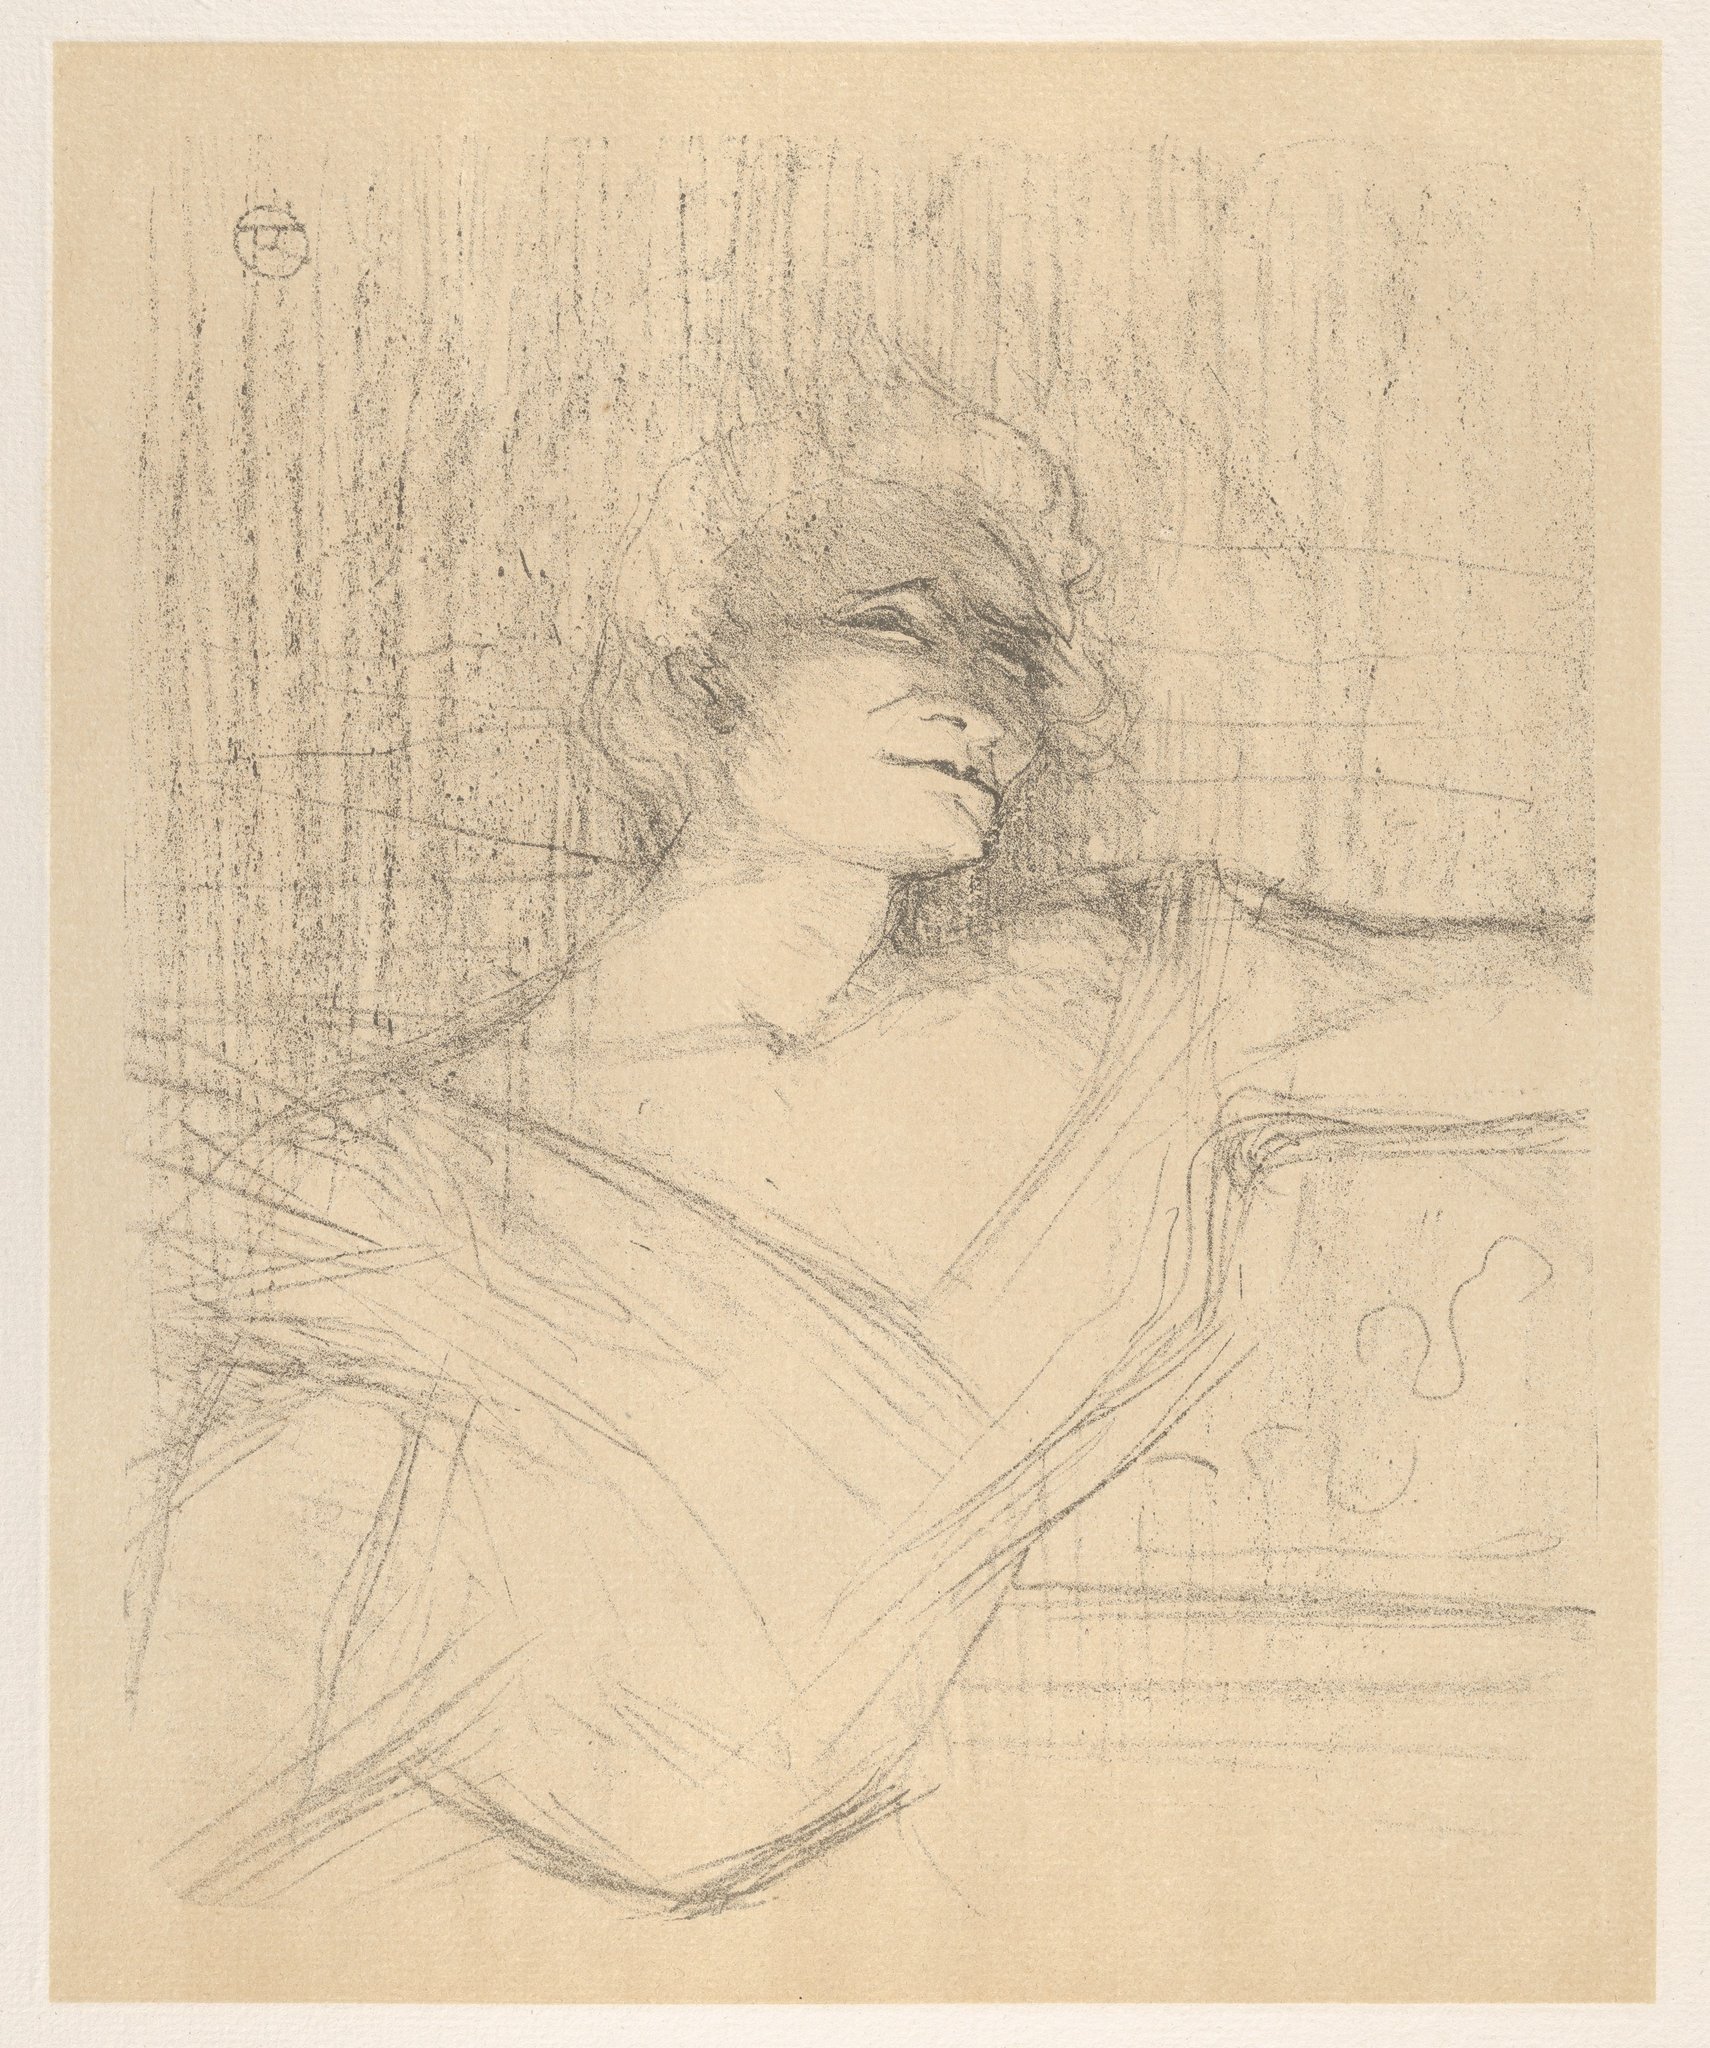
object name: print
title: II. Dans la Glu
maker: henri de toulouse-lautrec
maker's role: artist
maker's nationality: french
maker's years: 1864-1901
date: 1898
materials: paper, stone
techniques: lithograph, printing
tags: women